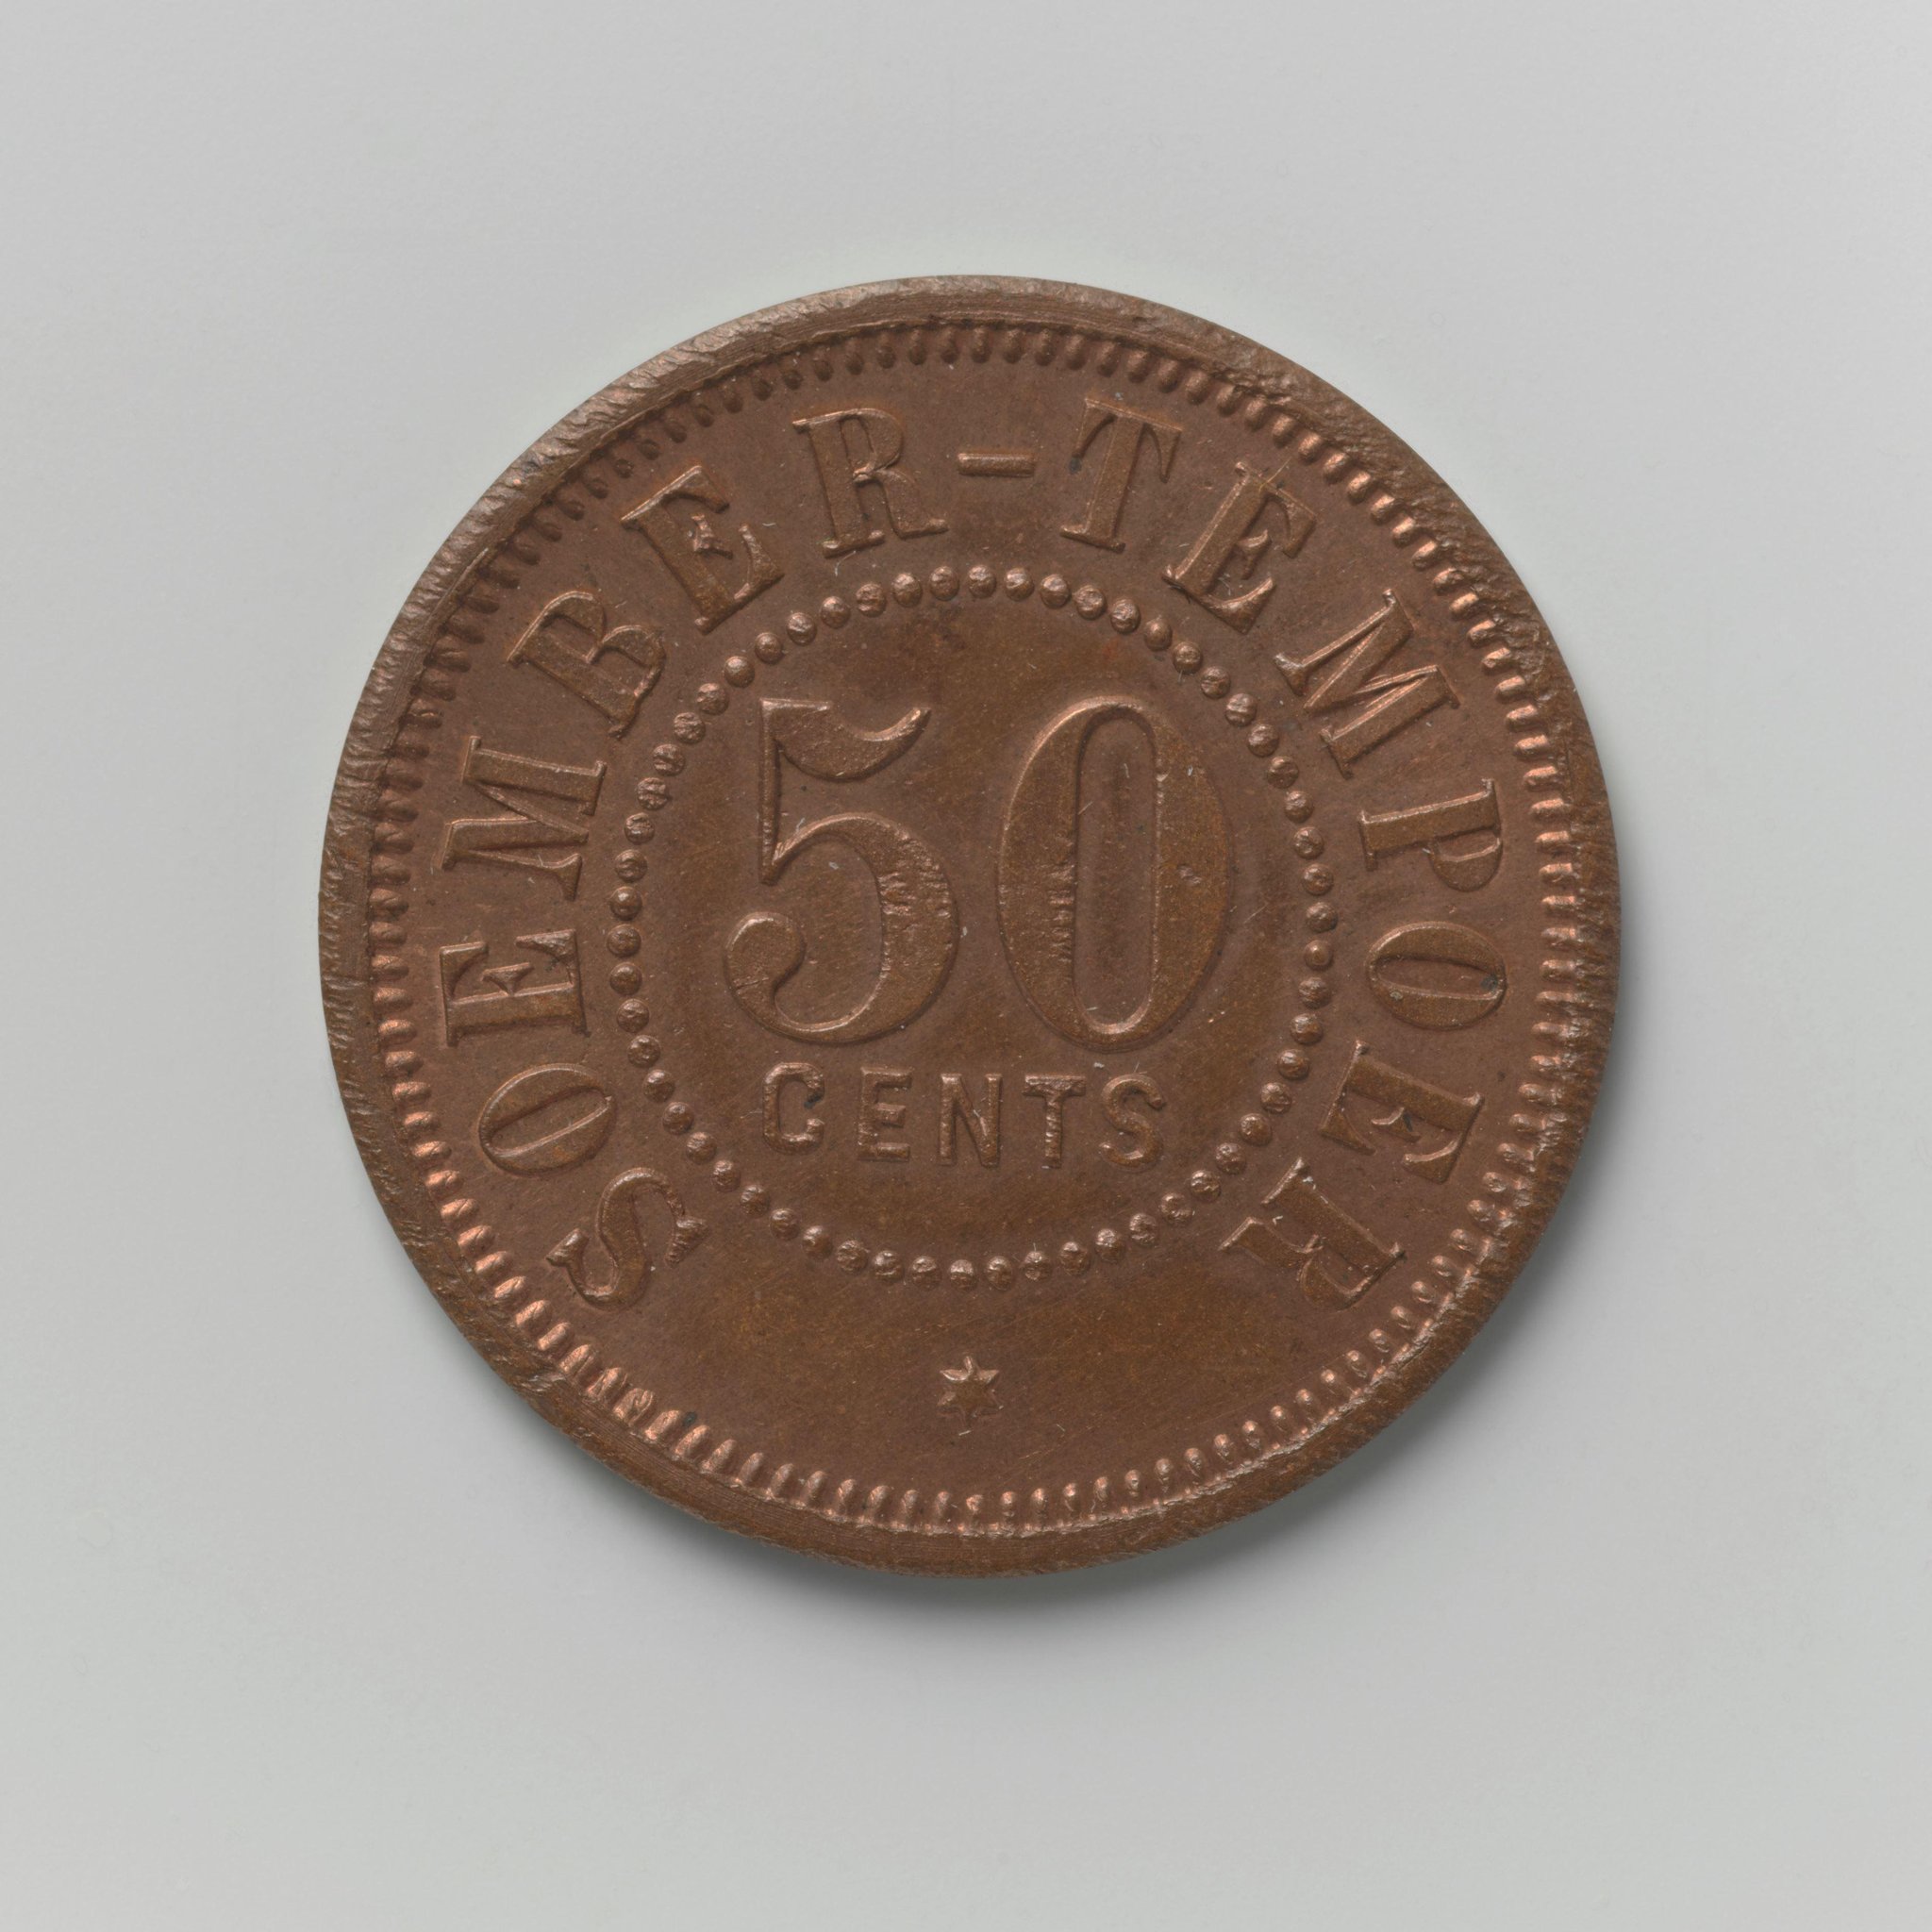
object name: vijftig cent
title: Plantage Soember Boeren, 50 cents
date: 1875-1925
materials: copper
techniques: striking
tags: plantage soember-tempoer, passoeroean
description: Koperen partuculiere munt. Plantage-geld. Voorzijde: in twee regels waarde-aanduiding. In omschrift aanduiding van de plantage. Keerzijde: in twee regels waarde-aanduiding. Gladde rand.